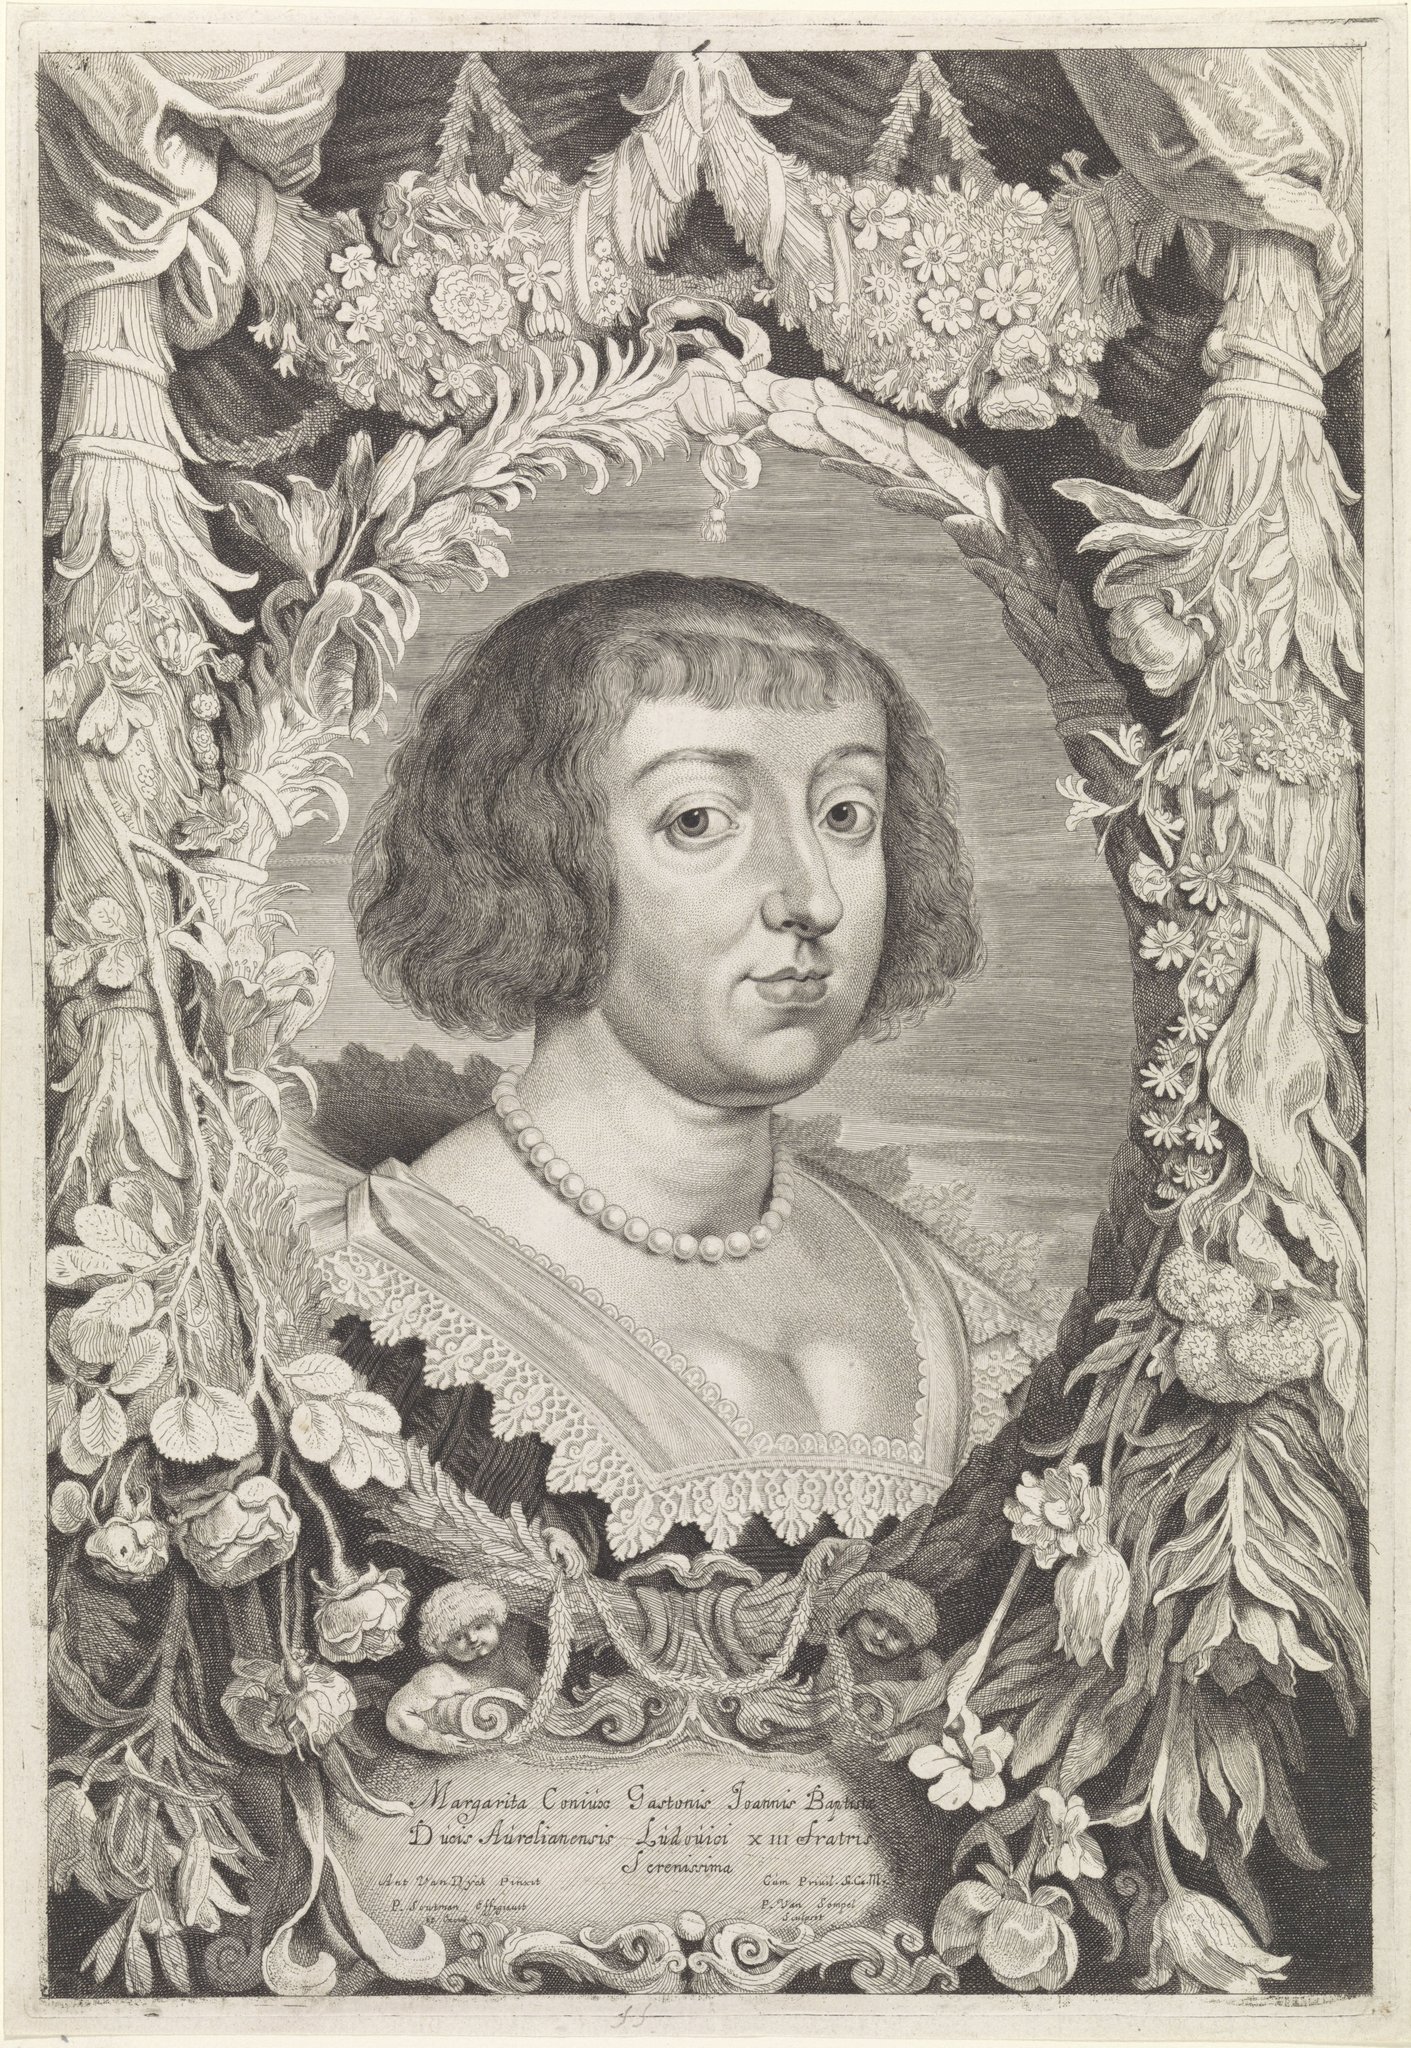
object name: print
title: Ferdinandus II[us] et III[us] Imperatorum Domus Austriacae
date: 1644-1650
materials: paper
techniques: engraving, etching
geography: haarlem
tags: paris, margaretha van lotharingen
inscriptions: collector's mark: Lugt 2228, collector's mark: Lugt 2760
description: Portret van Margaretha van Lotharingen, de tweede echtgenote van Gaston Jean-Baptiste, hertog van Orléans. Het portret wordt omlijst door guirlandes met bloemen. Onder het portret een cartouche met in het Latijn haar naam en die van haar echtgenoot en diens familierelatie tot de Franse koning Lodewijk XIII.